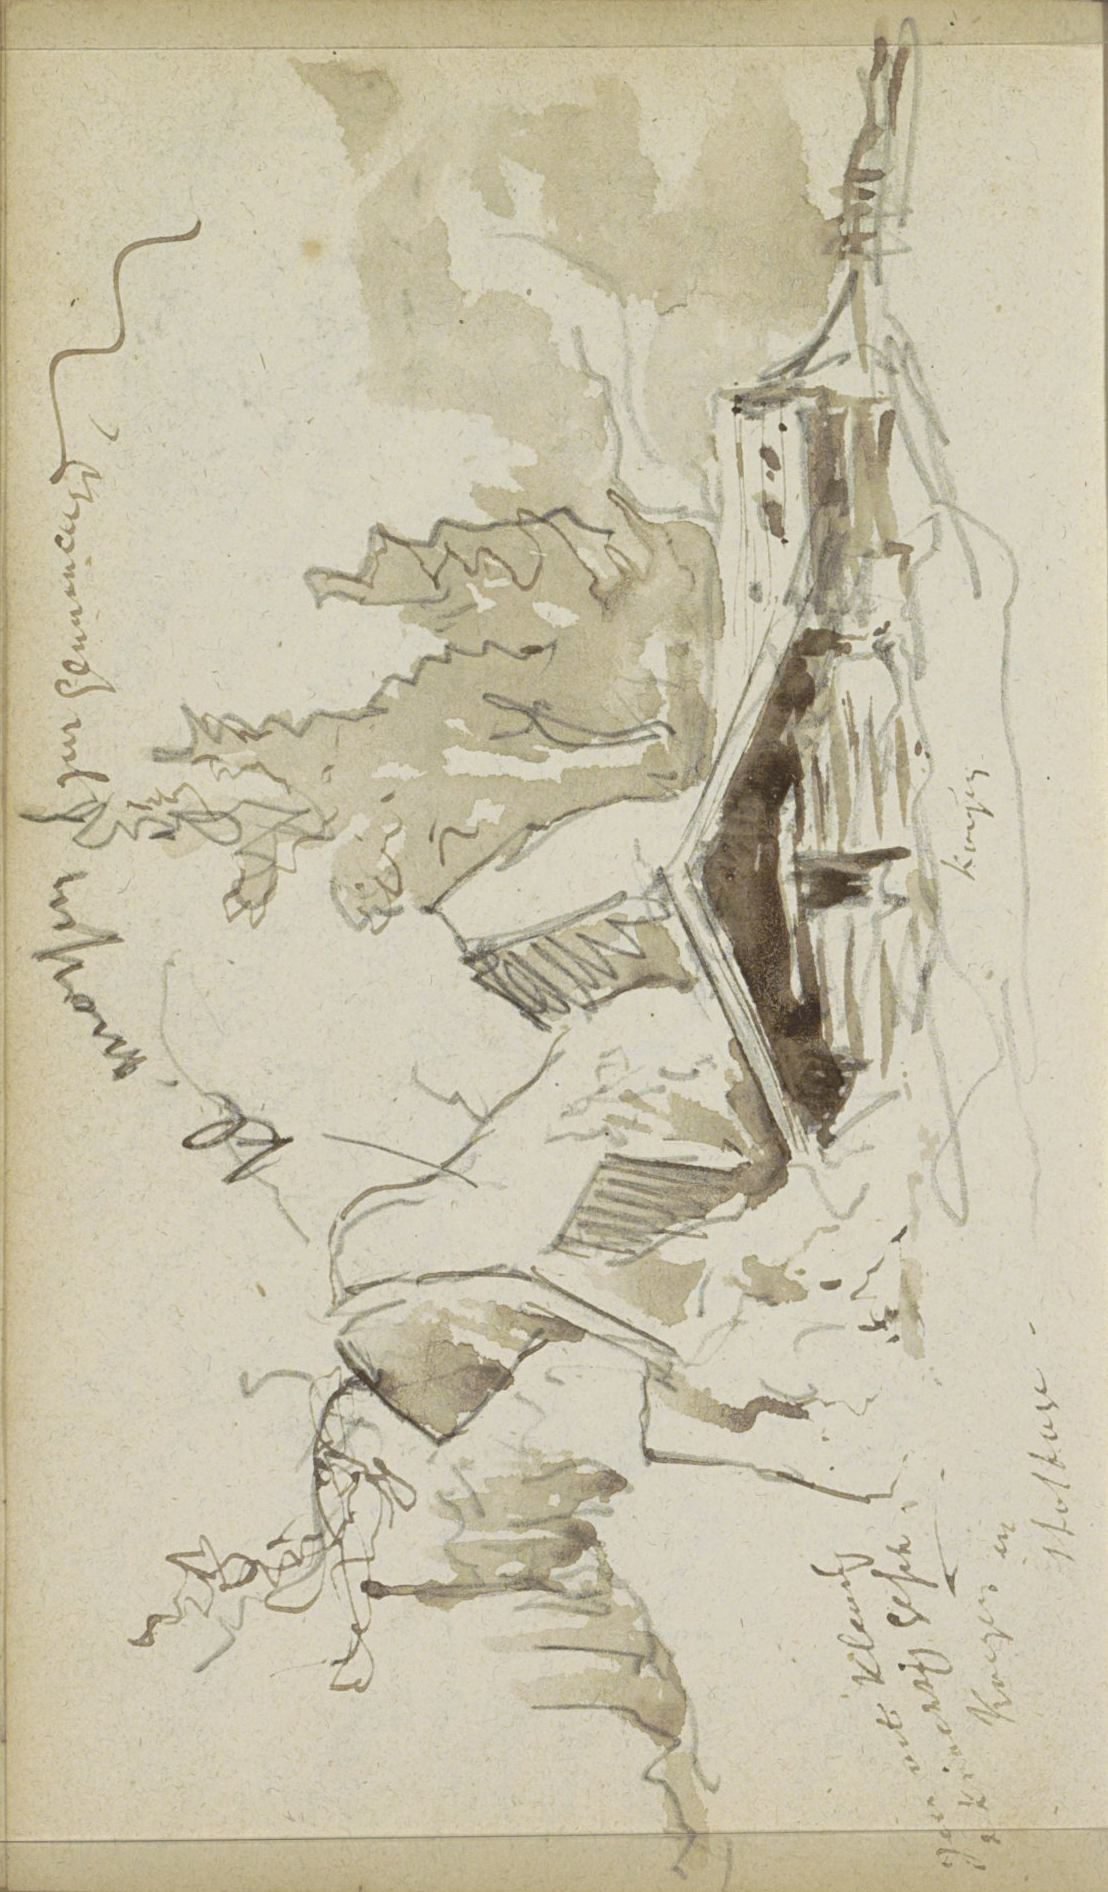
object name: sketchbook leaf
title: Huis tussen de bomen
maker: johannes tavenraat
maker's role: draughtsman, painter, print maker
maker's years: 1809-1881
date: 1854-1868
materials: ink, paper, pencil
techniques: brush, pen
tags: trees, rural housing, e.g. country-house, villa, cottage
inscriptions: kleurnotitie, handgeschreven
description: Blad 78 verso uit een schetsboek met 88 bladen.